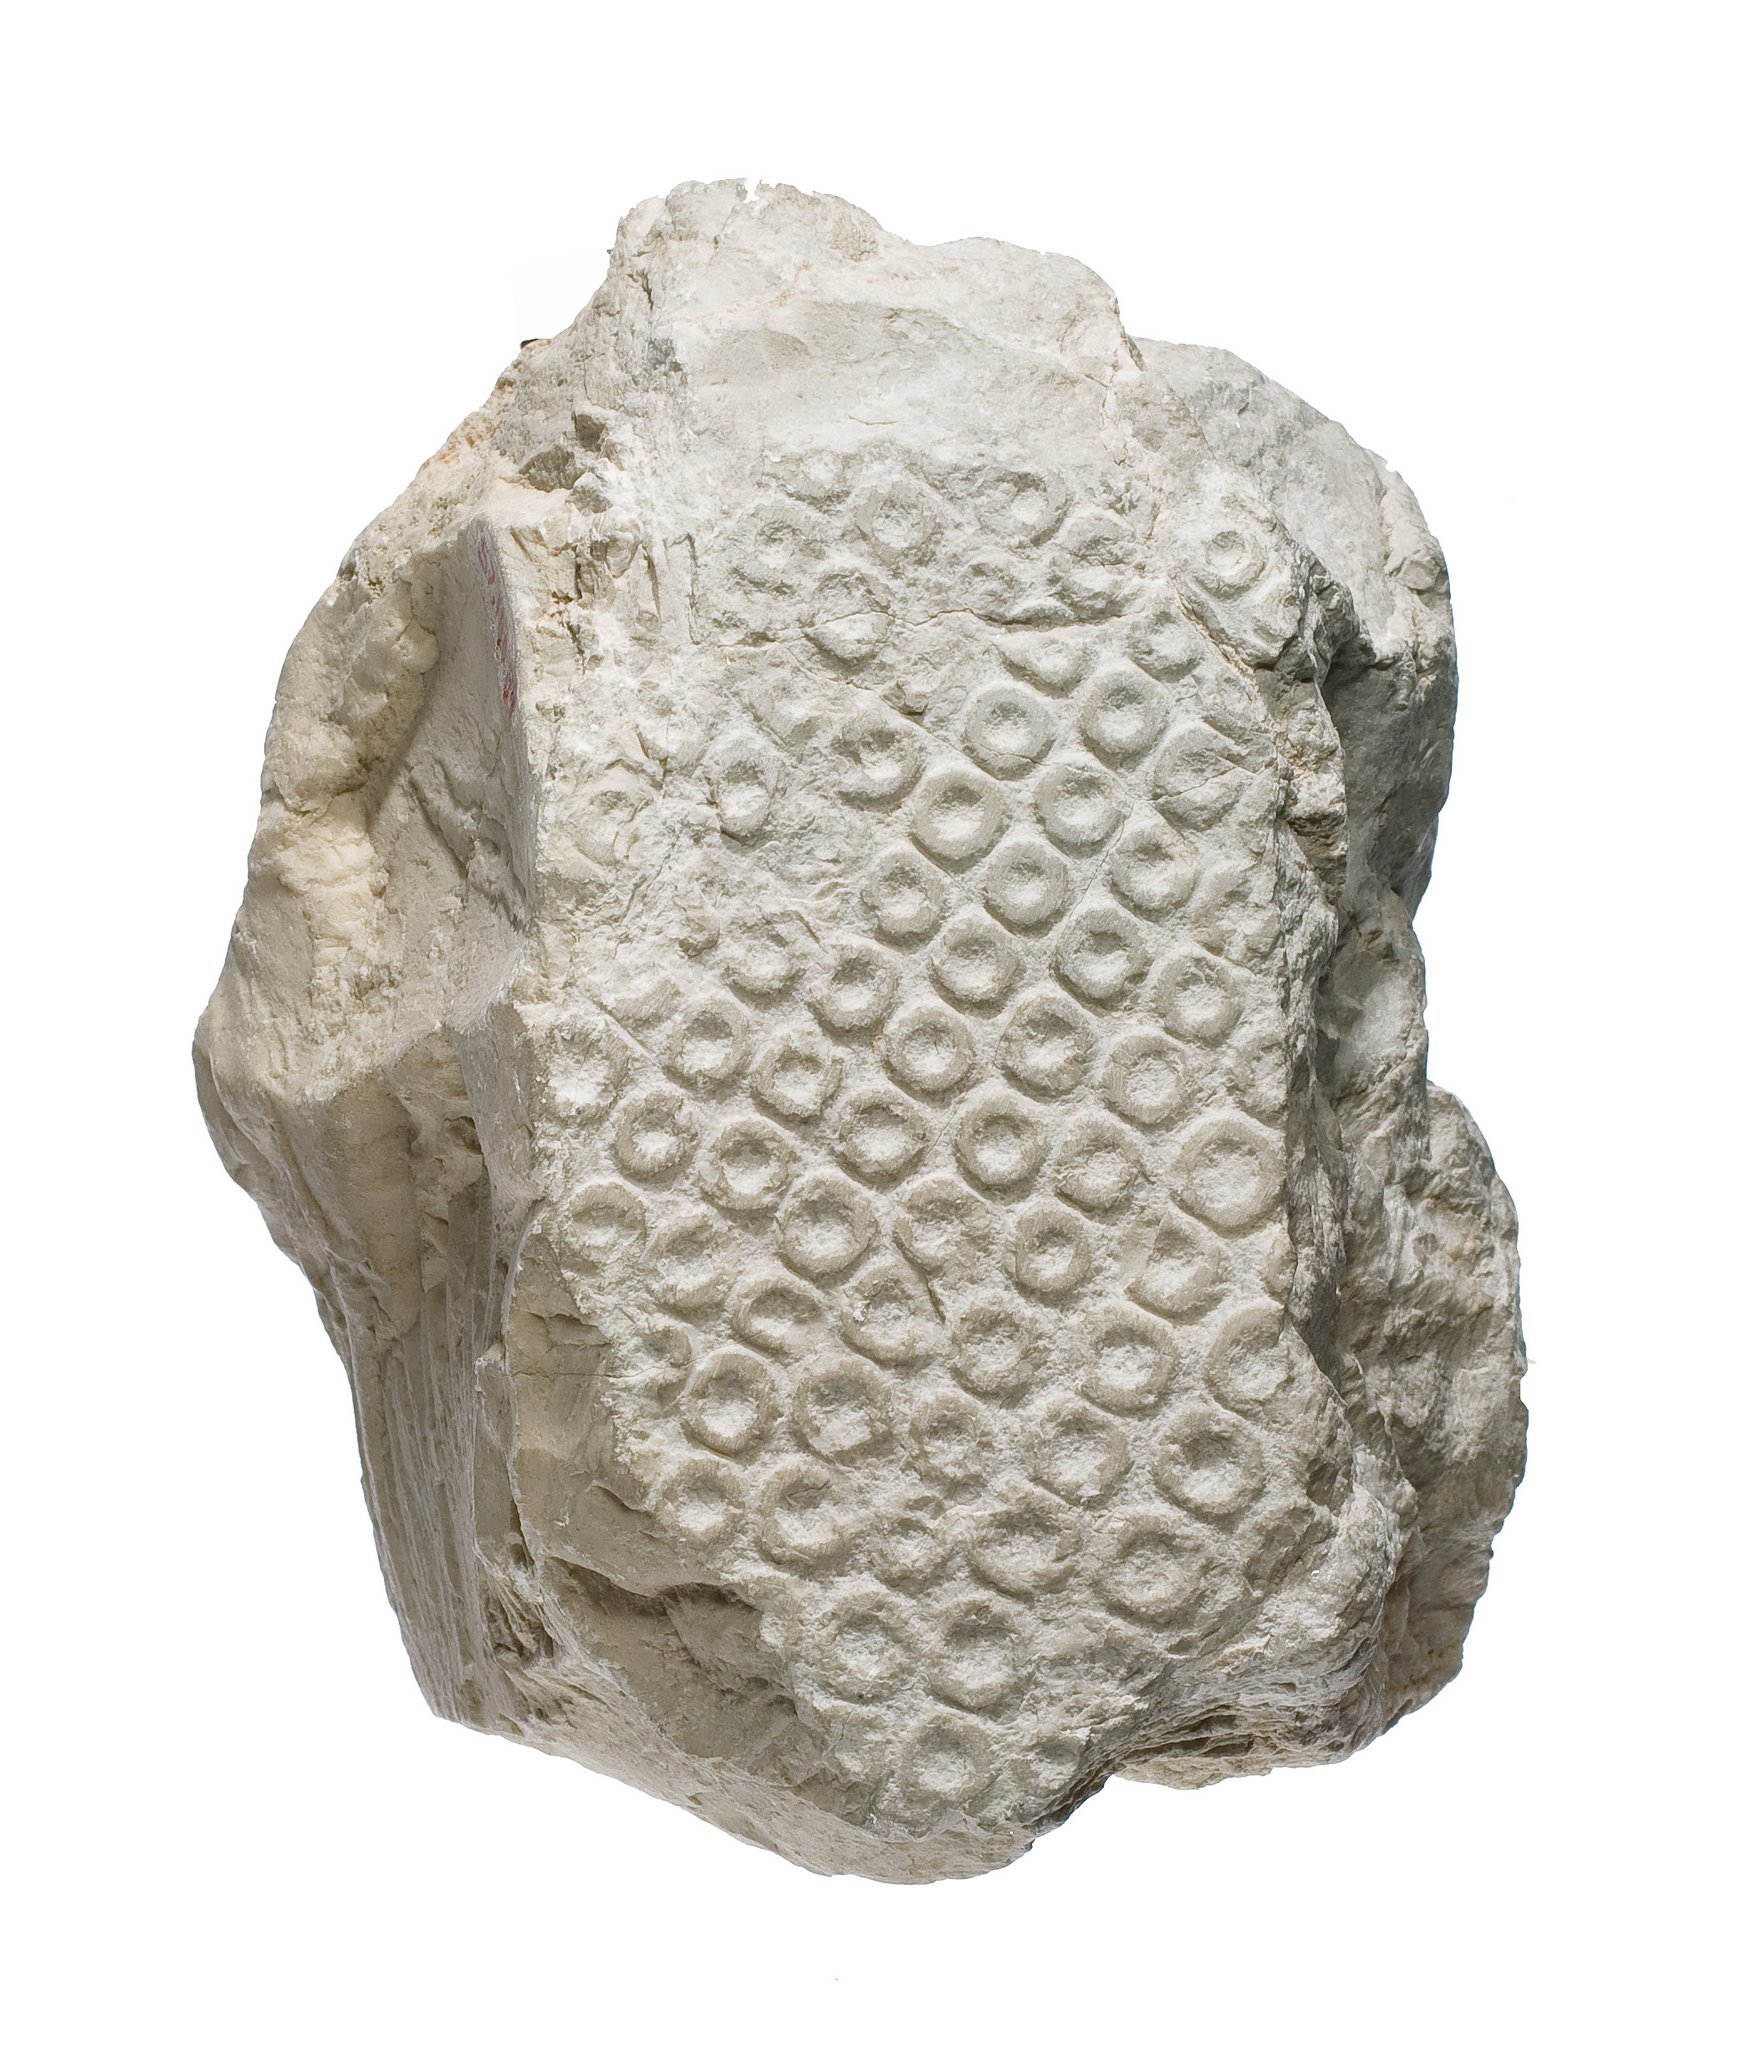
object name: head of akhenaten, blue crown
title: Crown with disks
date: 1353-1336 BCE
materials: limestone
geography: egypt